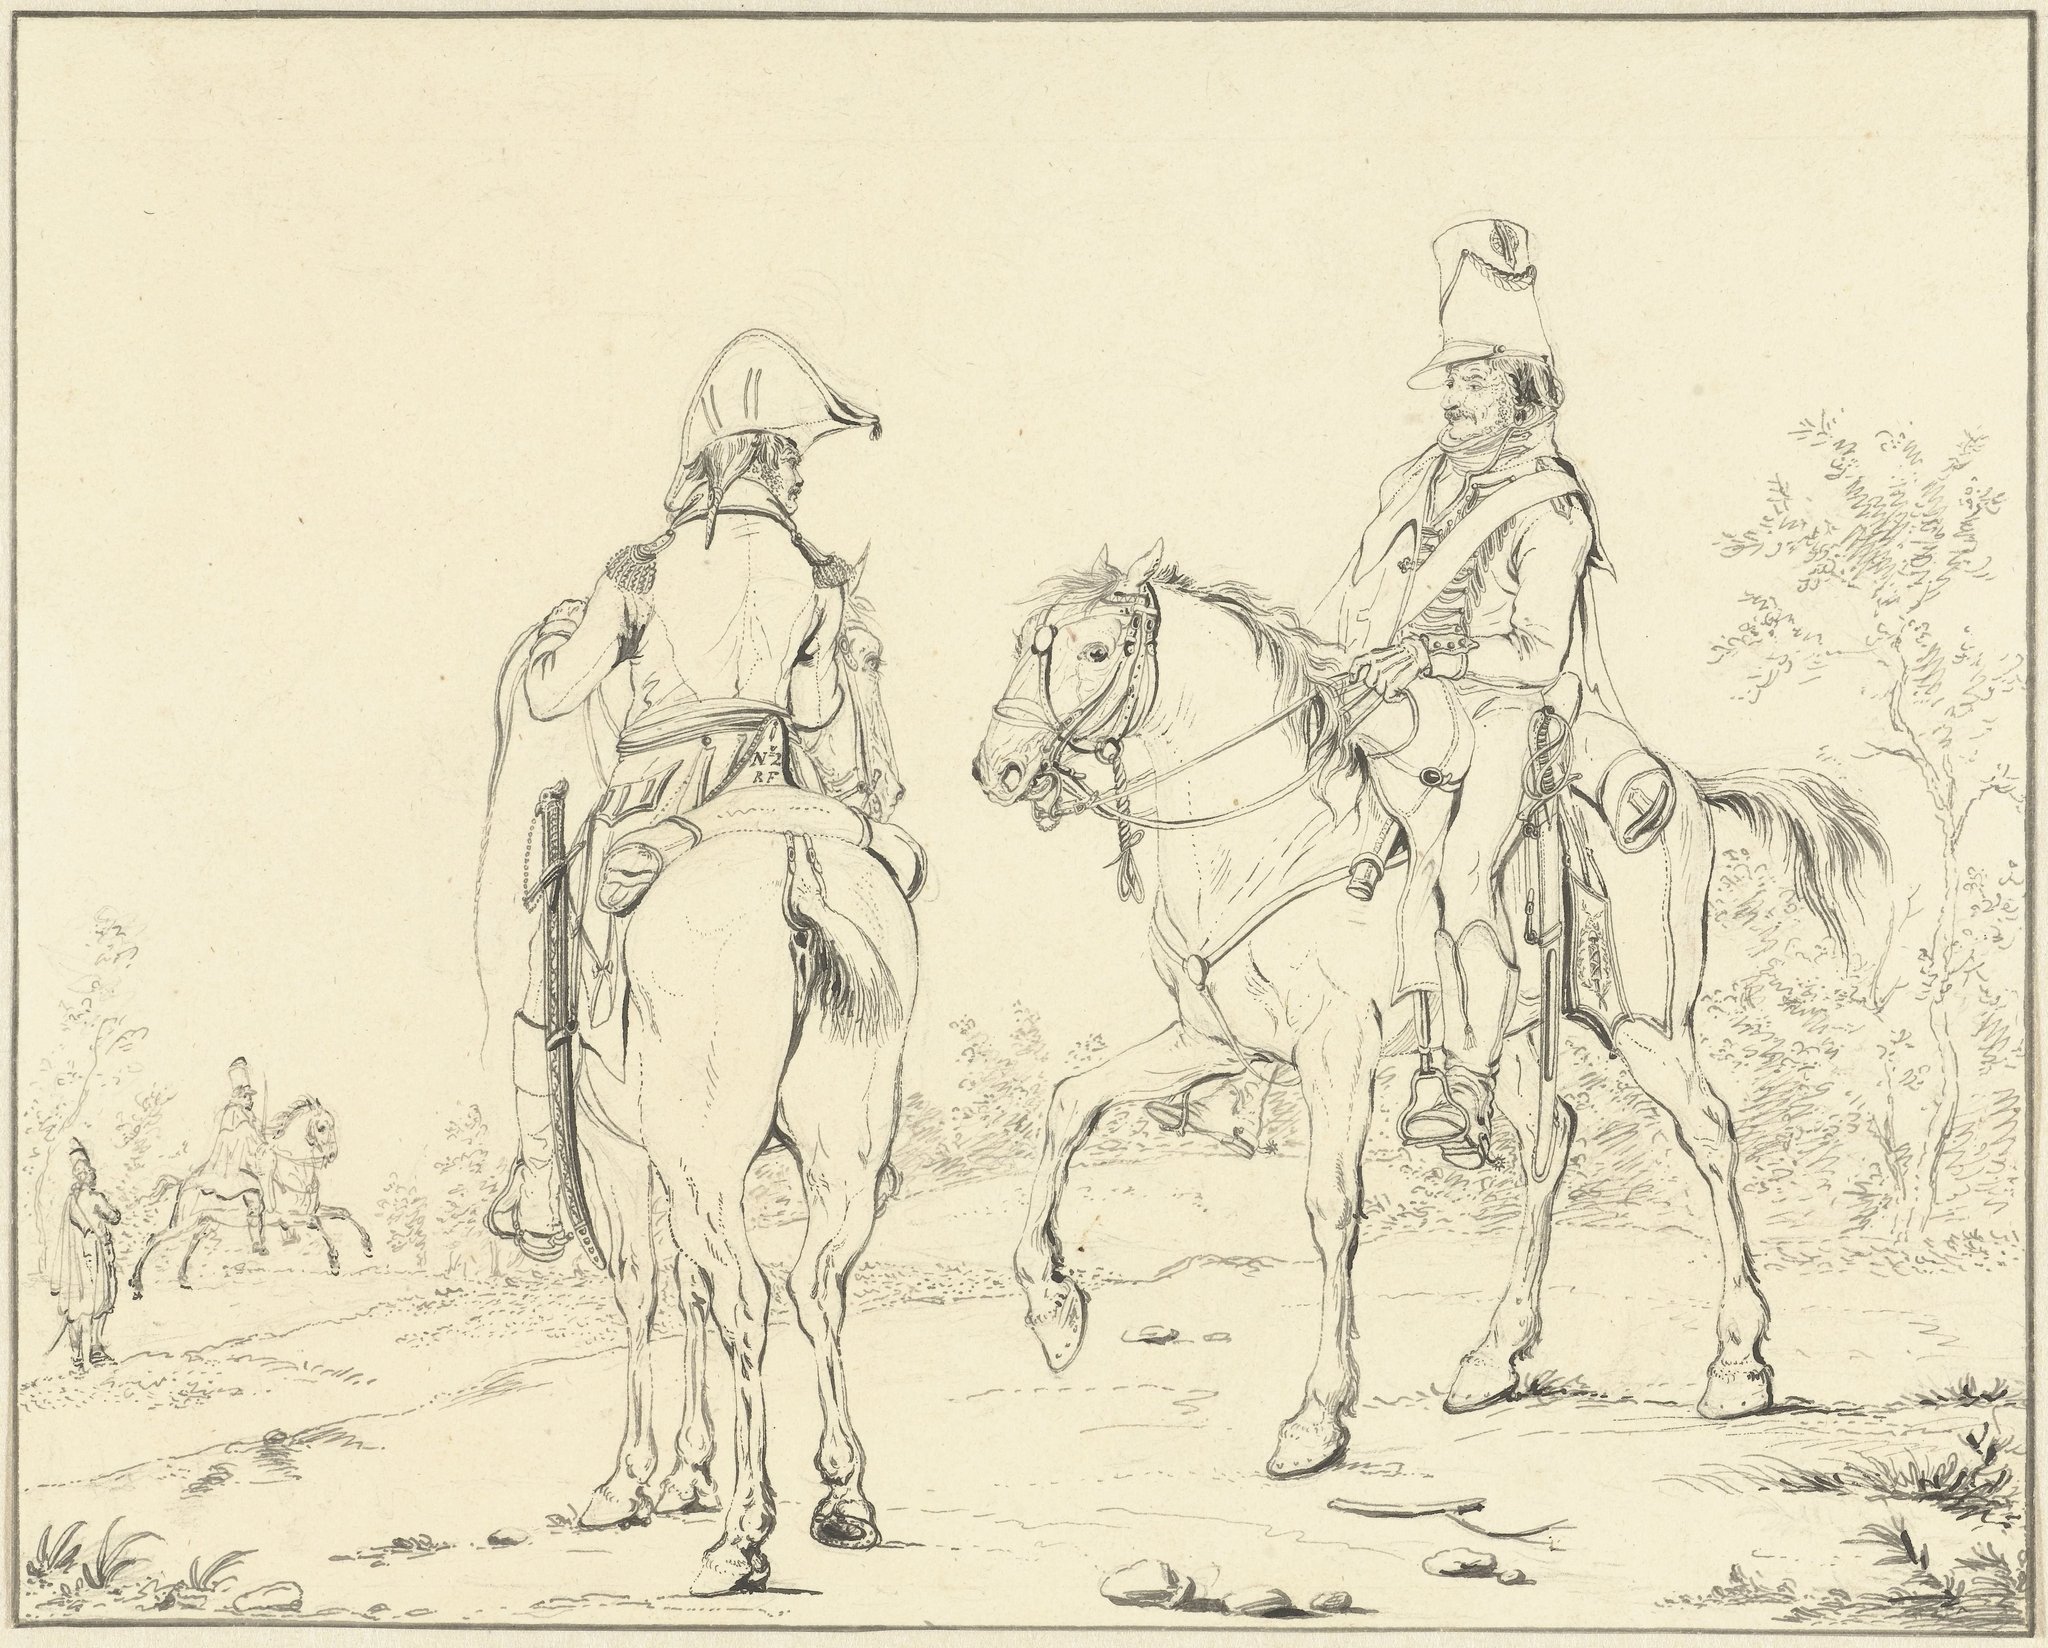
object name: drawing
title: Twee franse cavaleristen te paard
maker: johannes vinkeles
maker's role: draughtsman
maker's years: 1783-1803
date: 1802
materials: ink, paper, pencil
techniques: pen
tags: land forces (+ cavalry, horsemen), horse